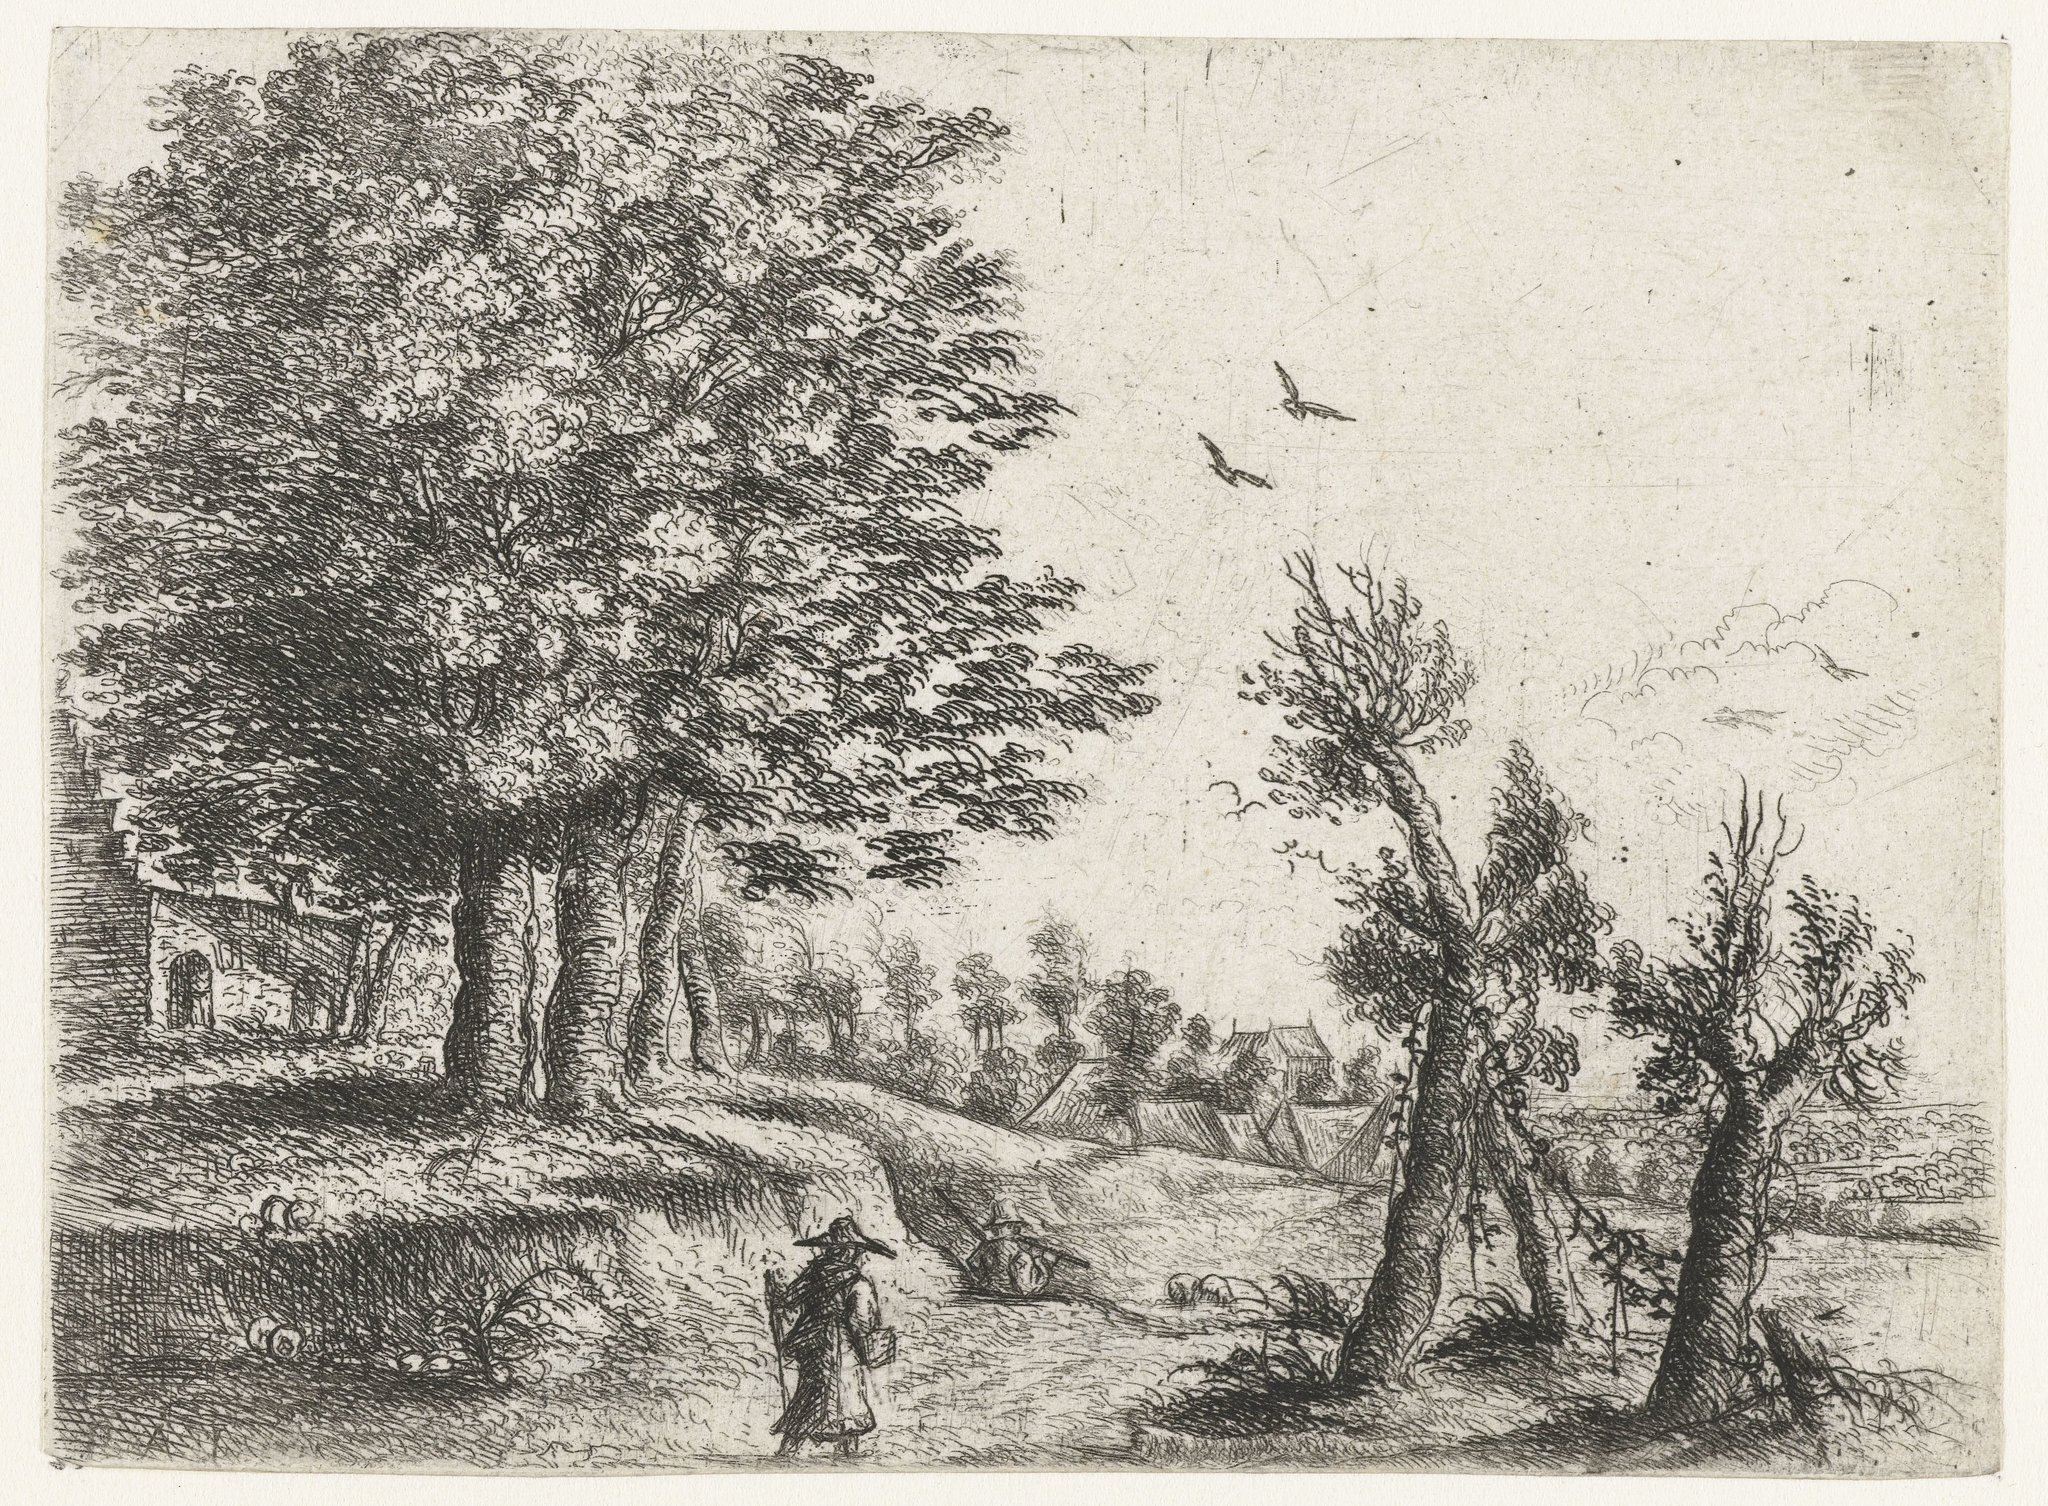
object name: print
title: Landschap met een vrouw en een fluitspelende herder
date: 1637-1679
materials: paper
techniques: engraving, etching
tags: herding, herdsman, herdswoman, shepherd, shepherdess, cowherd, etc., one person playing wind instrument, landscapes in the temperate zone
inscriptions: collector's mark: Lugt 240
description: Achtste uit serie van acht. Landschap met een wandelende vrouw en een zittende herder spelend op een fluit.